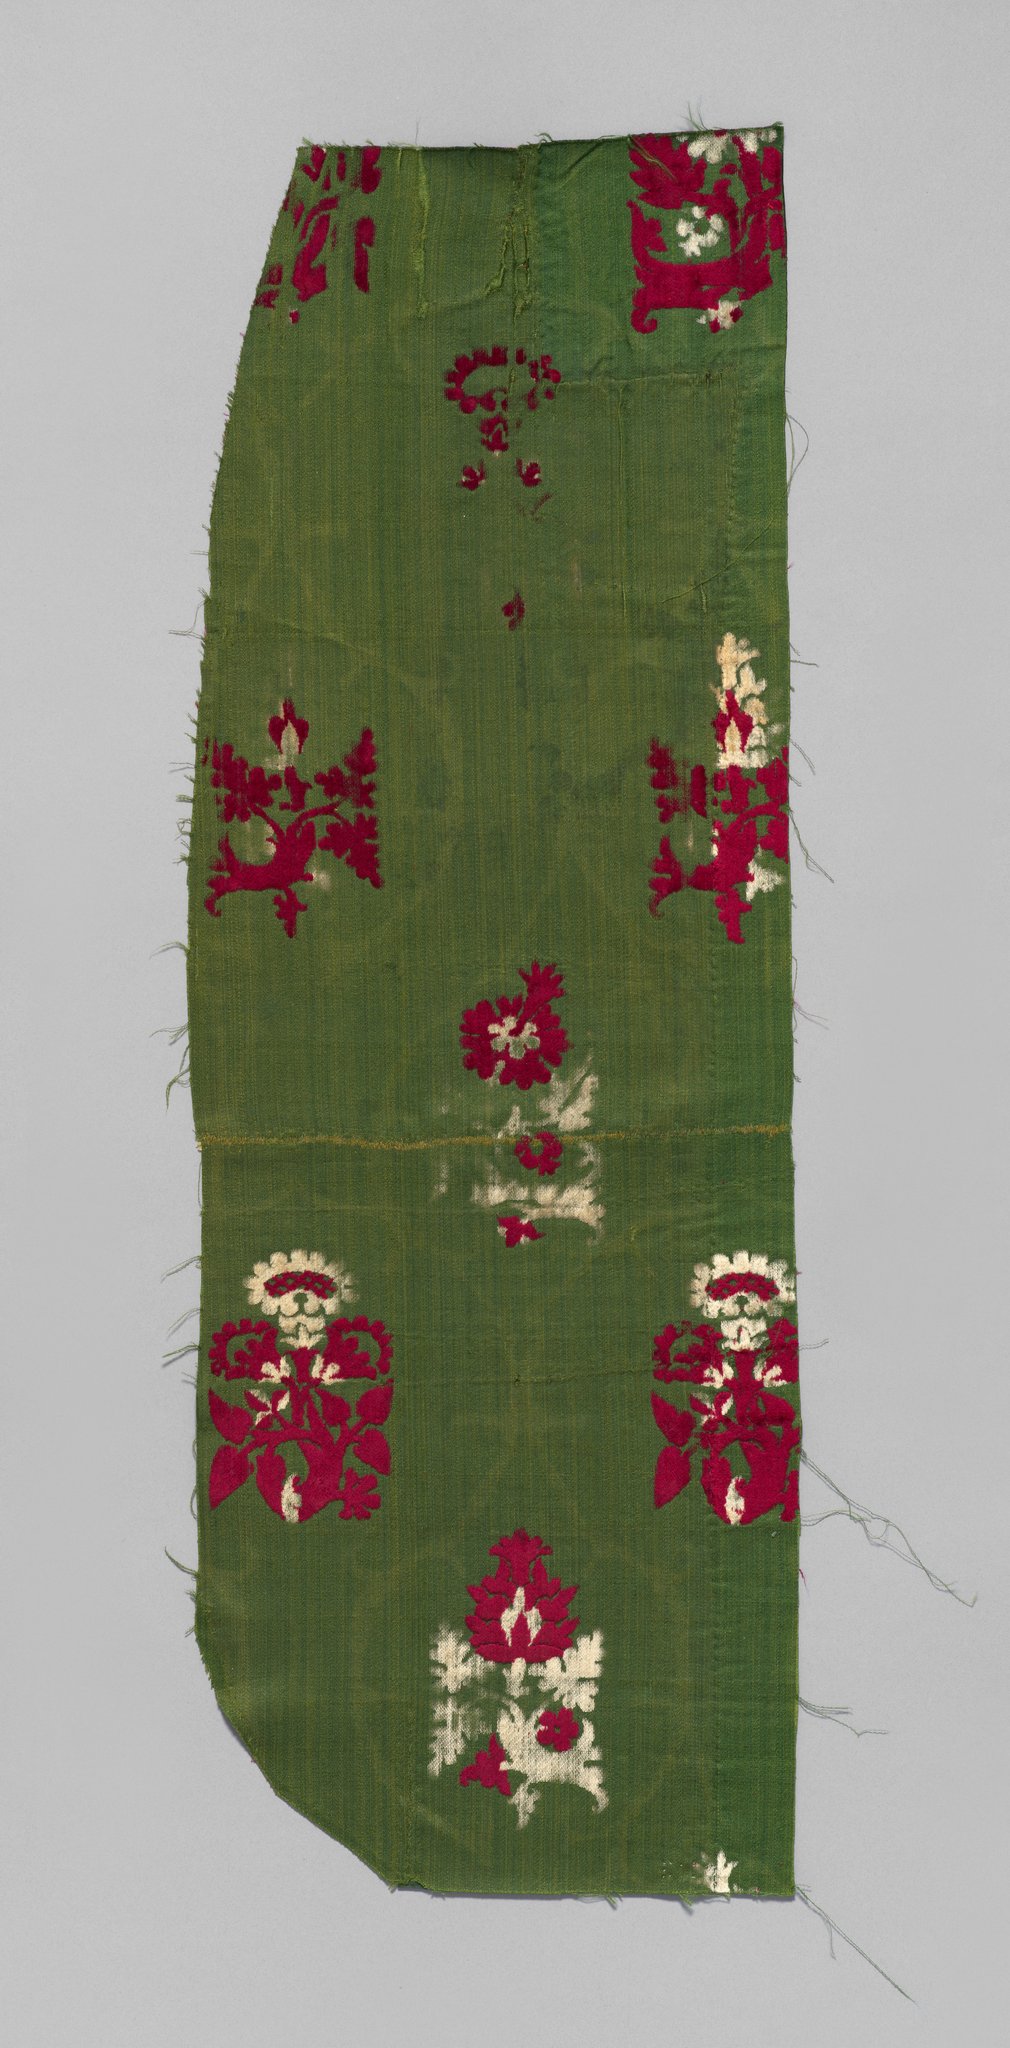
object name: piece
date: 1434-1466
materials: silk